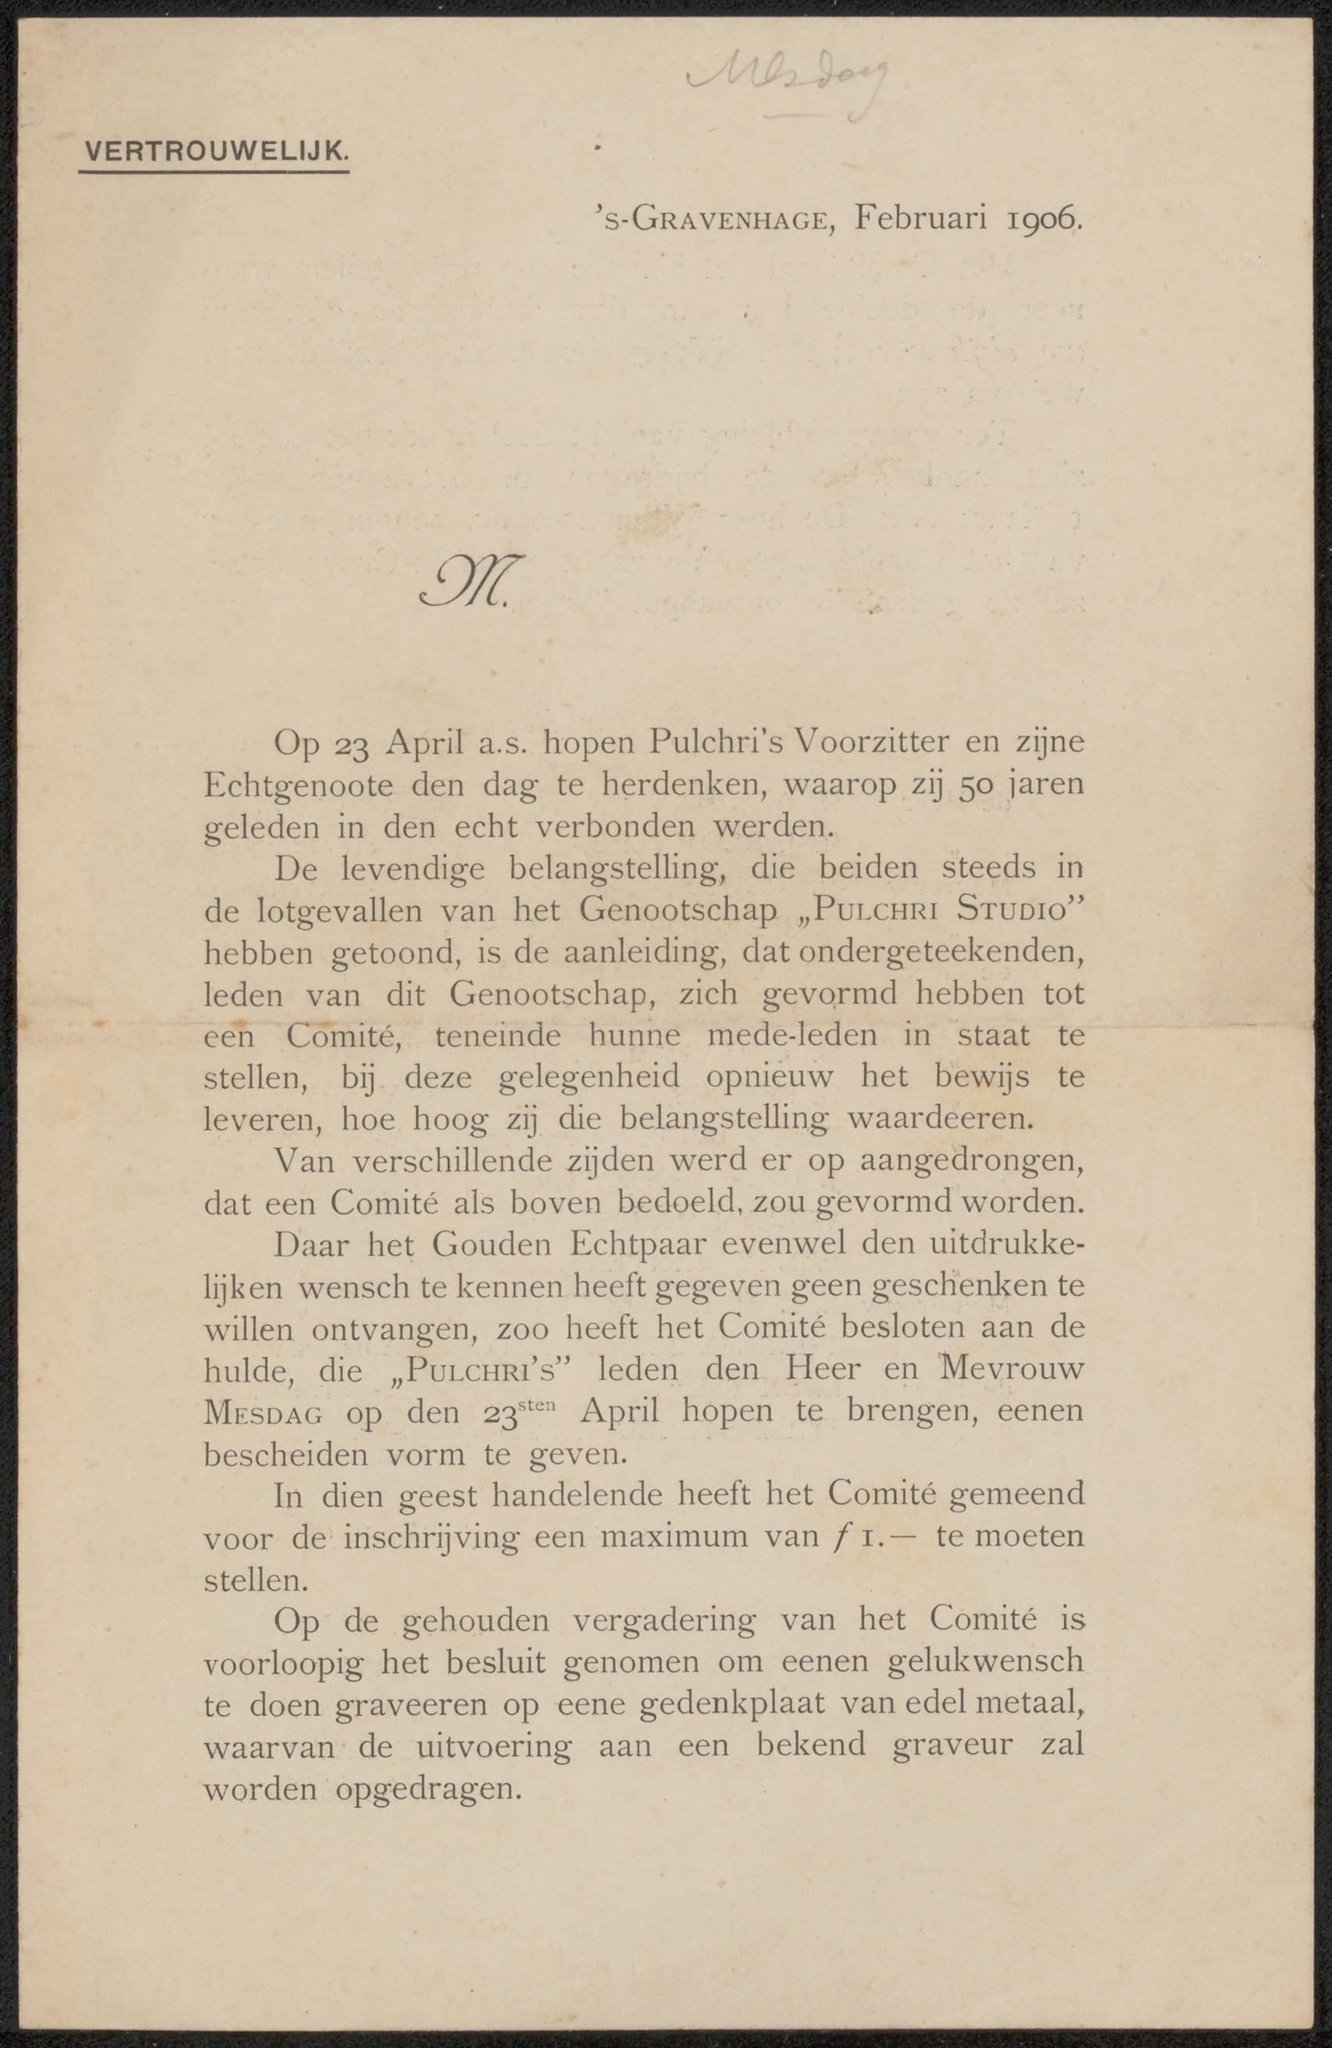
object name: letter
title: Brief aan Philip Zilcken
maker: frits jansen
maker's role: painter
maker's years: 1856-1928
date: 1902-1906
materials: paper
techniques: printing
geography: the hague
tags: painter, print maker, draughtsman, hendrik willem mesdag, sientje mesdag-van houten, philip zilcken